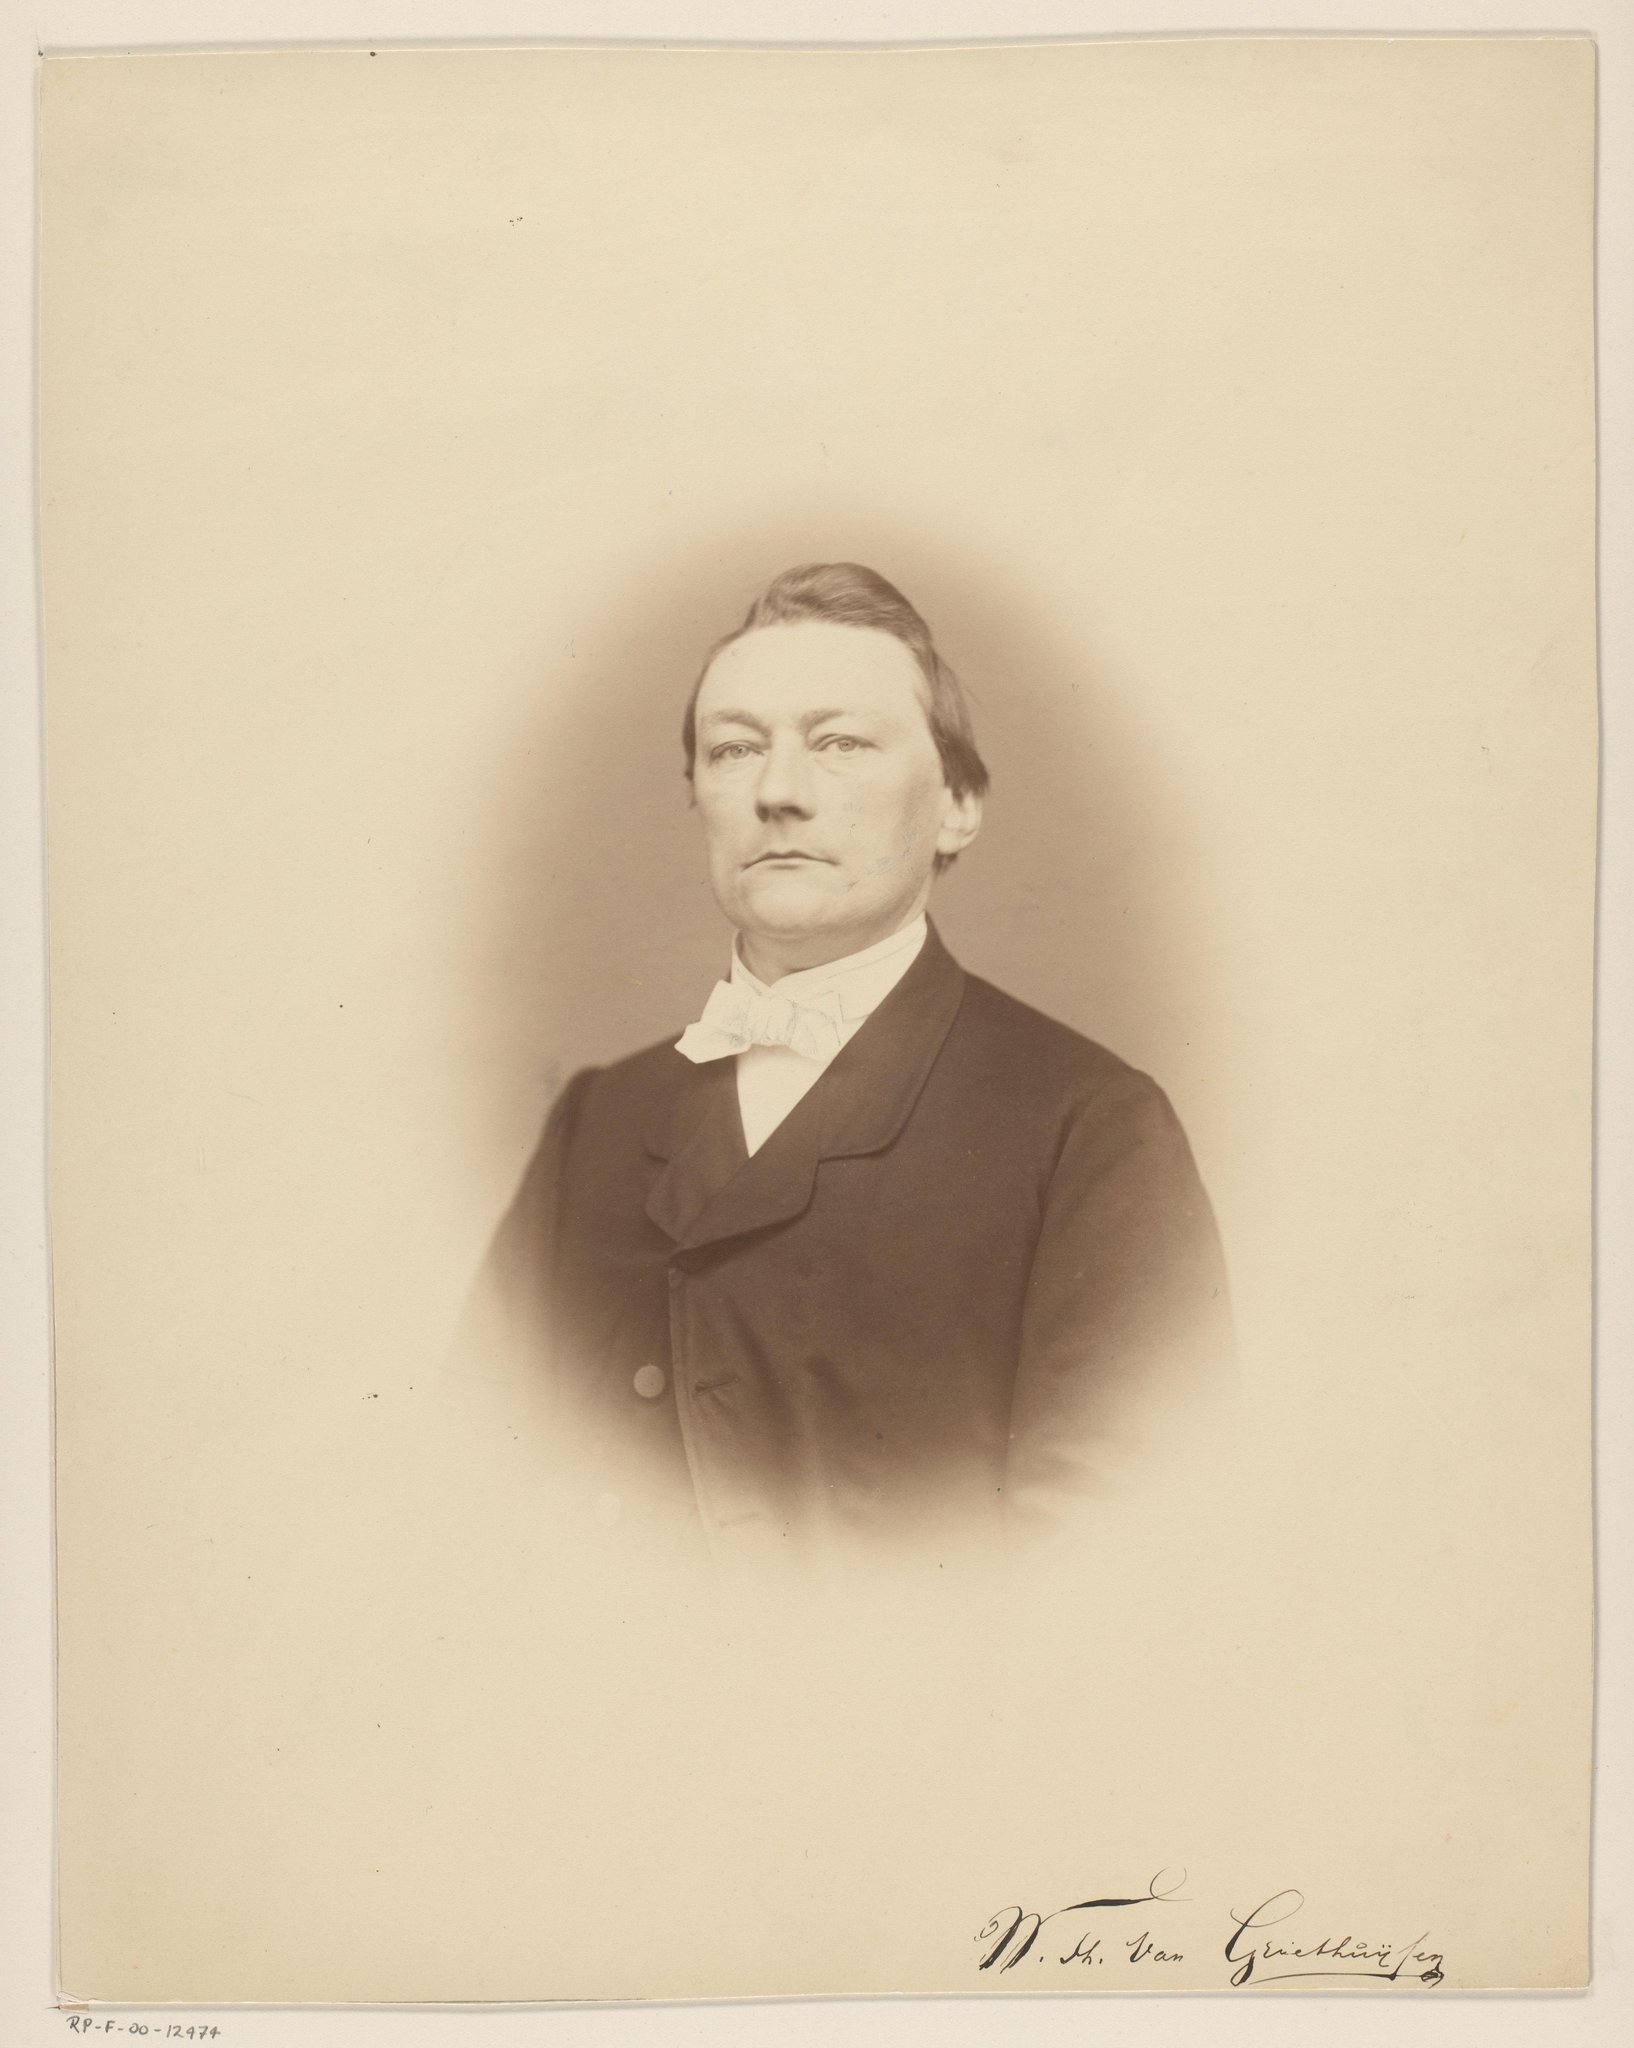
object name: photograph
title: Portret van Willem Theodorus van Griethuysen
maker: Anonymous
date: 1860-1886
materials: cardboard, paper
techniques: albumen print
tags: historical persons, functionaries and dignitaries (with name) ~ episcopal protestant churches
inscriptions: signature: ‘W.Th. van Griethuysen’